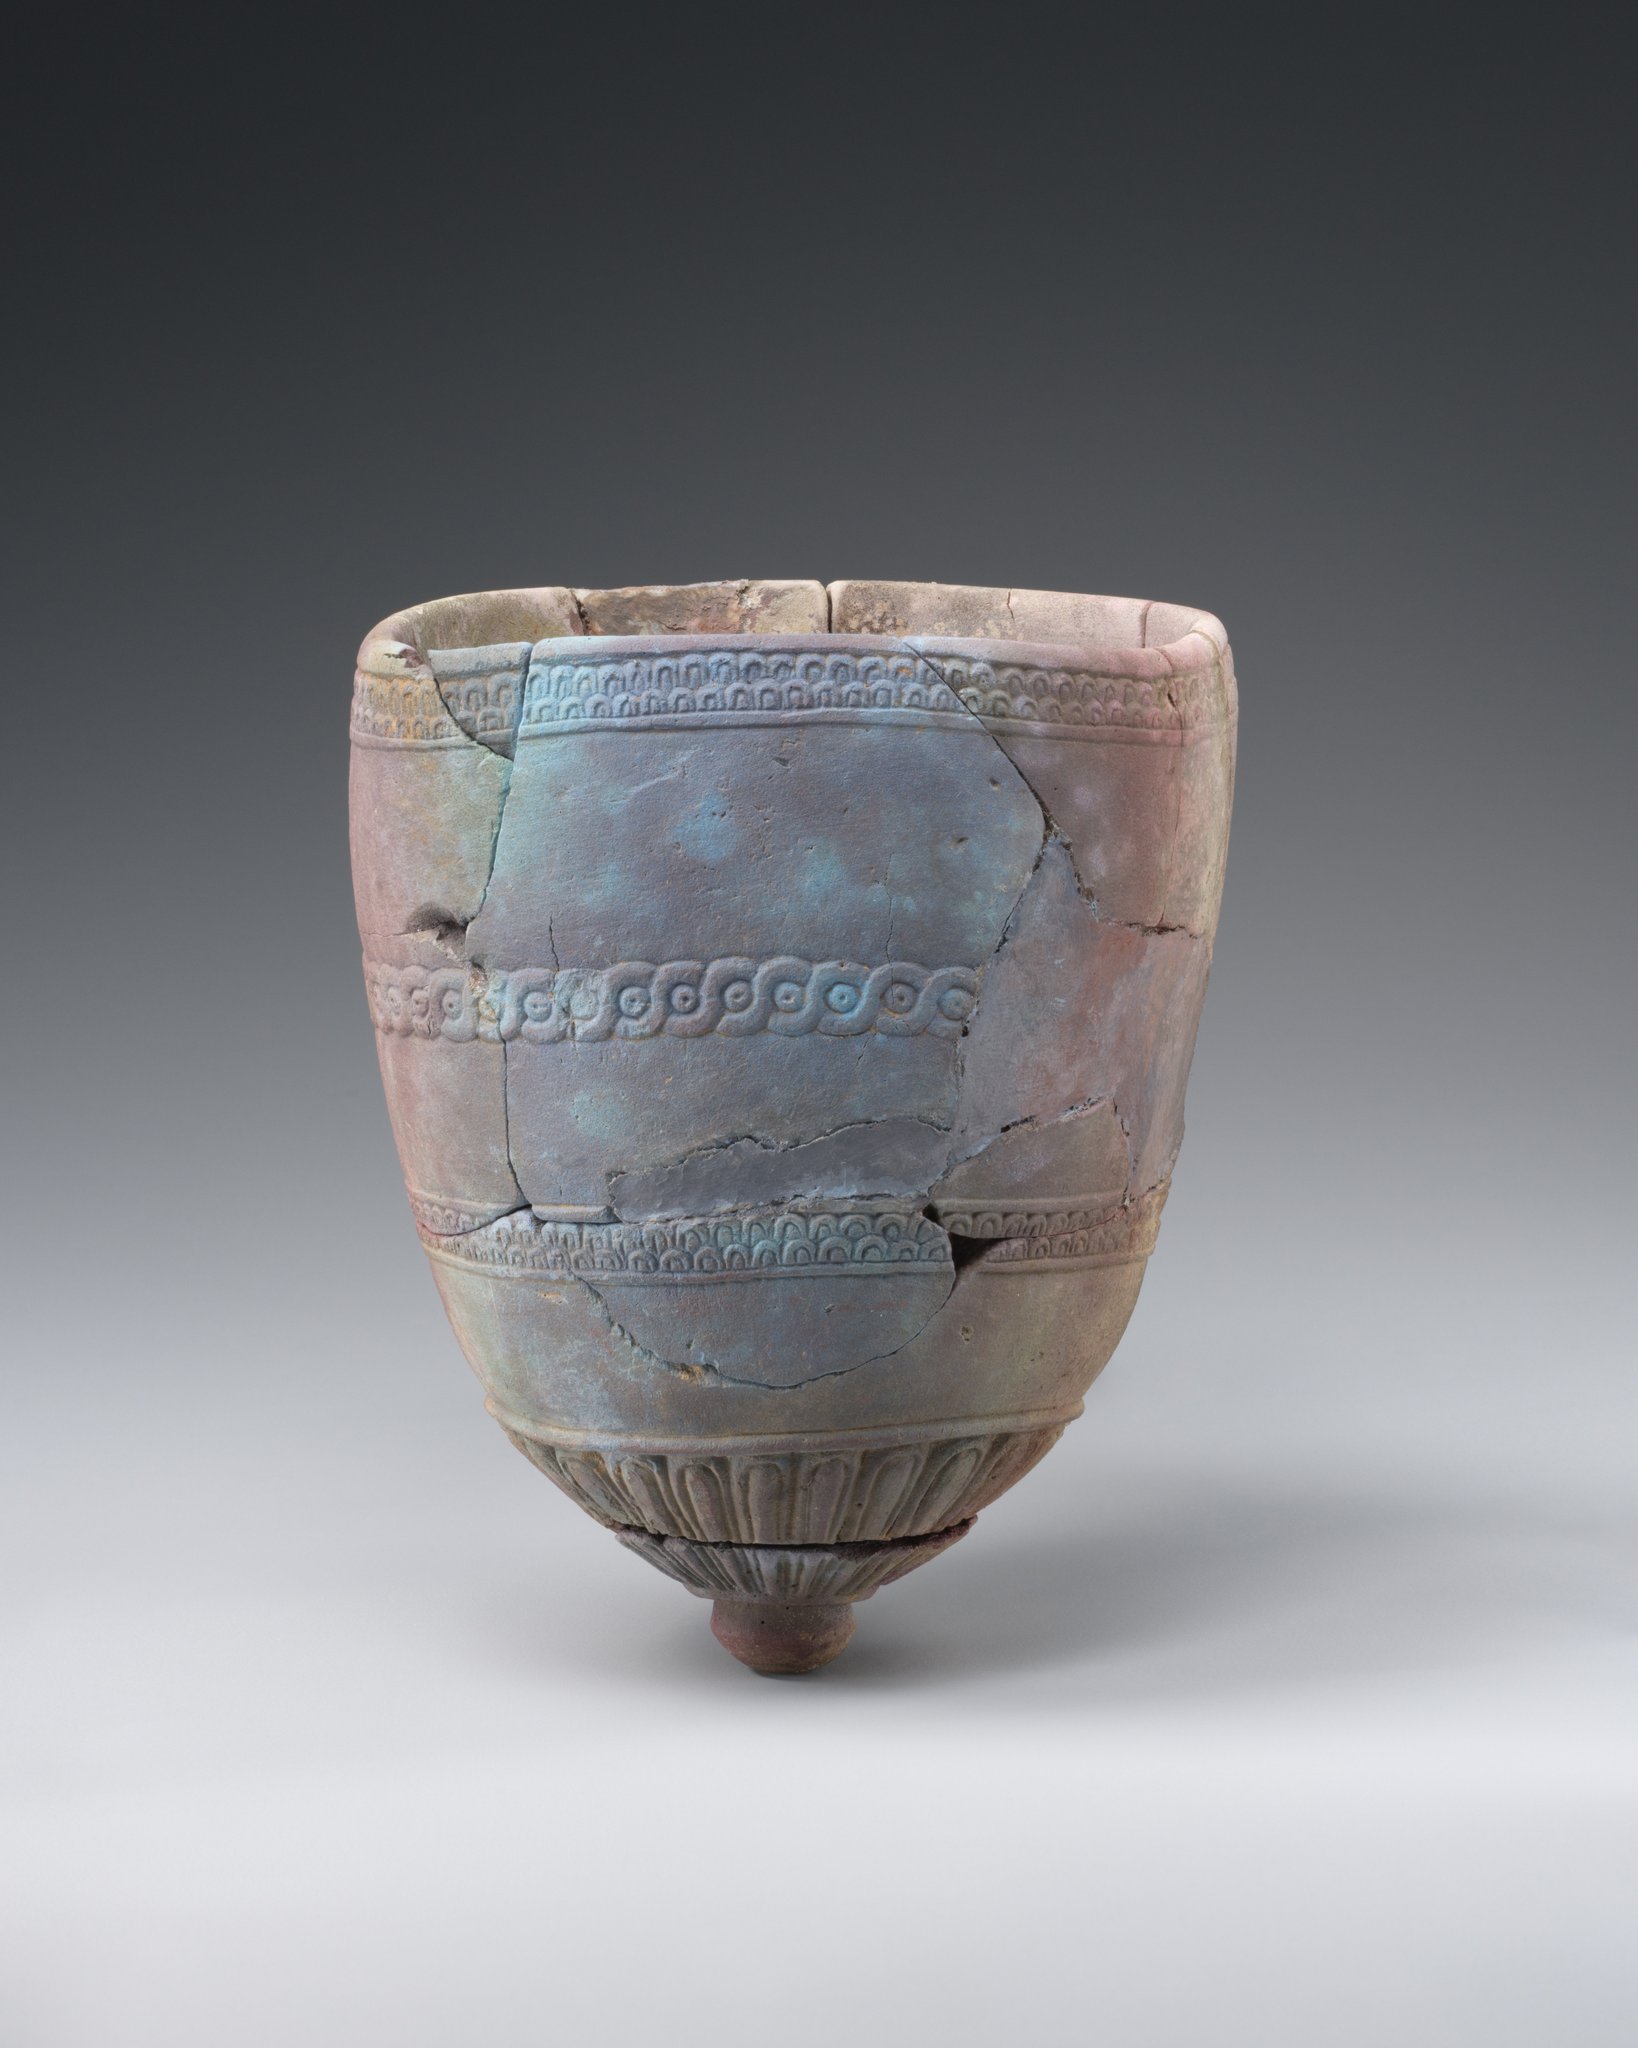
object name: beaker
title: Beaker with tongue and guilloche patterns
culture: iranian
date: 900-801 BCE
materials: glass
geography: iran